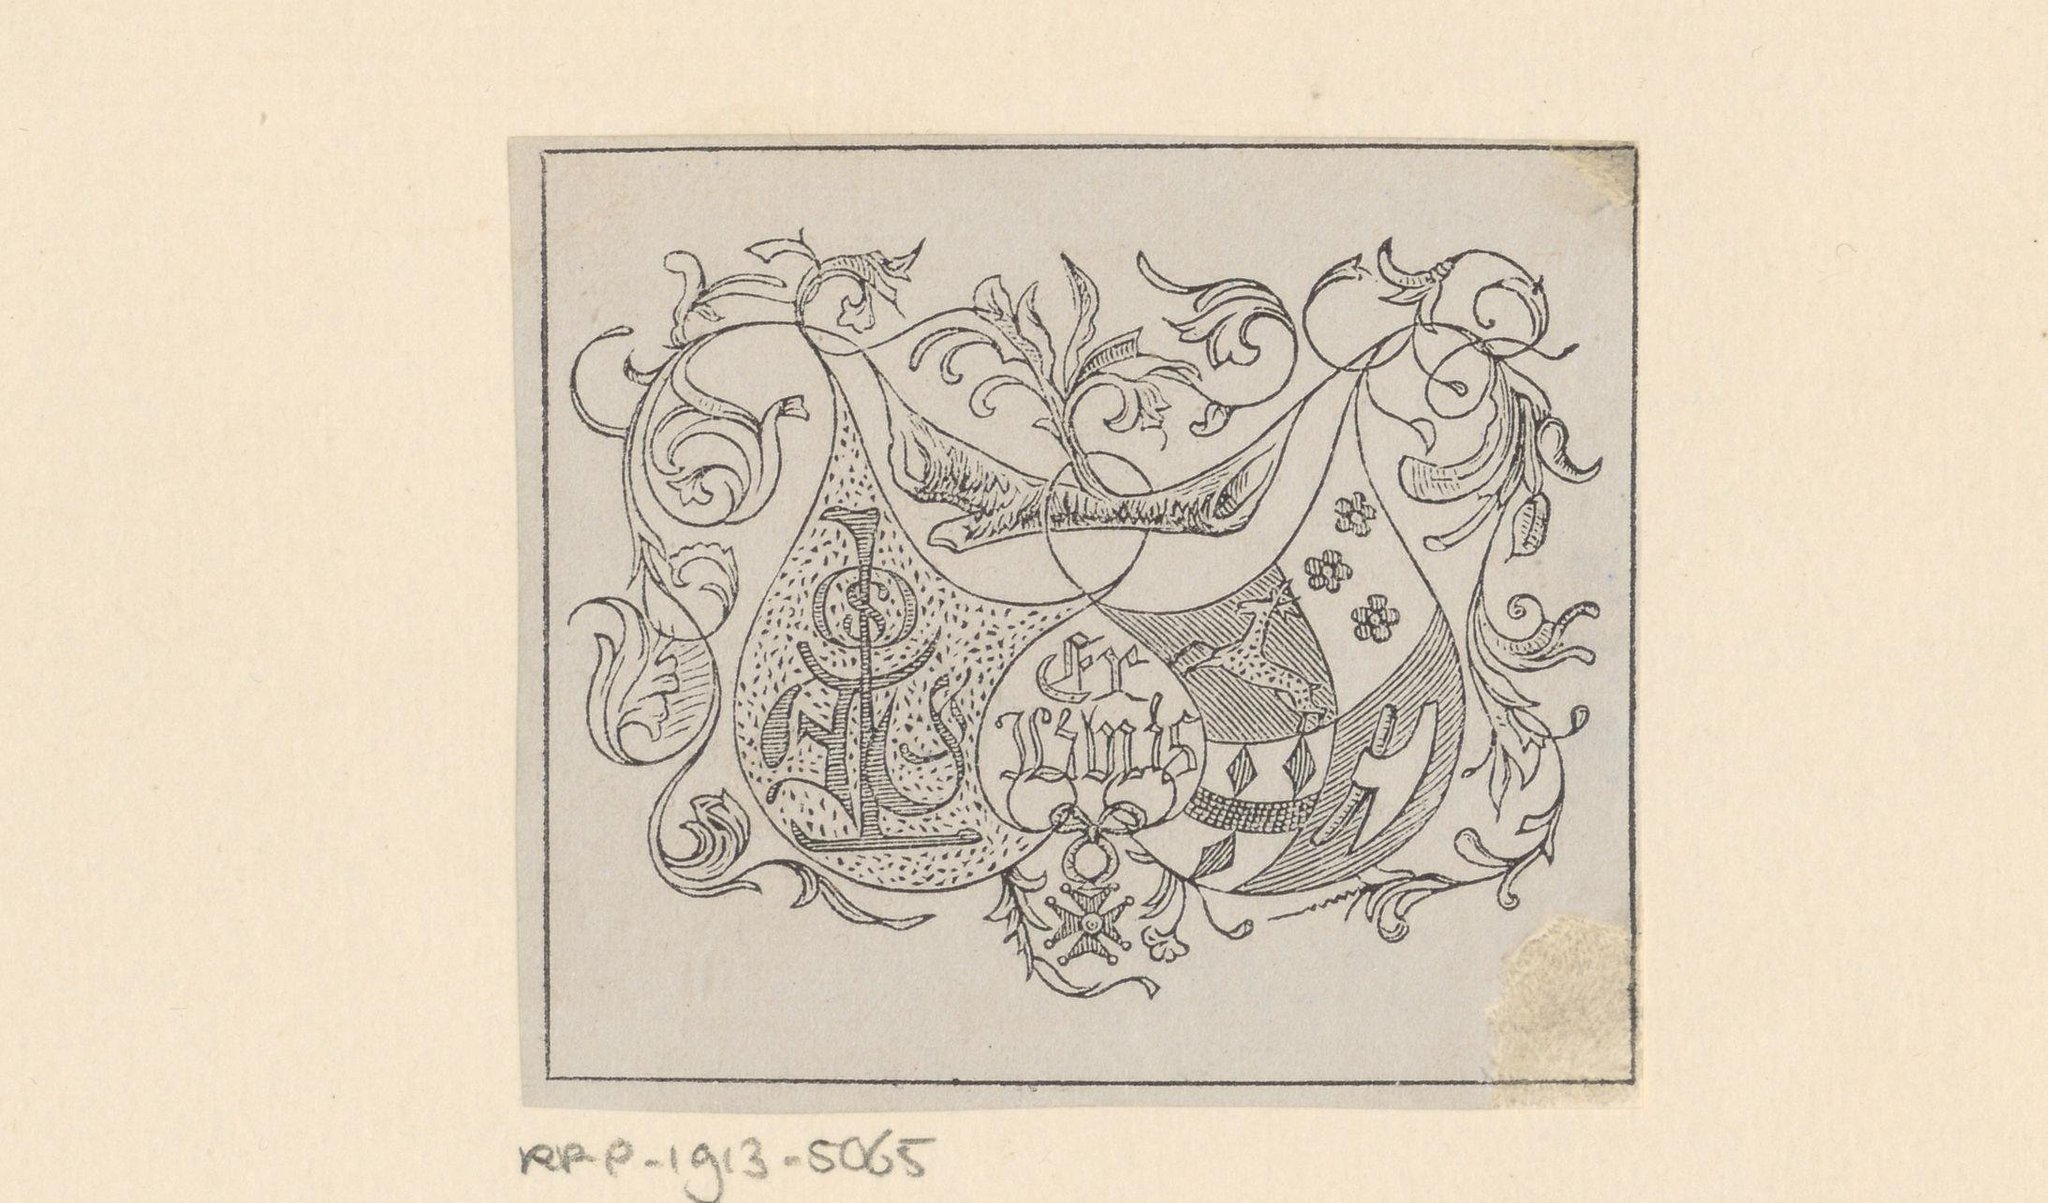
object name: bookplate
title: Ex libris van J.A. Alberdingk Thijm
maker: Anonymous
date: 1830-1889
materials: paper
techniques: engraving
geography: netherlands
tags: amsterdam, painter, draughtsman, publisher, josephus albertus alberdingk thijm, foliage ~ ornament, armorial bearing, heraldry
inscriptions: collector's mark: Lugt 2760, collector's mark: Lugt 2233